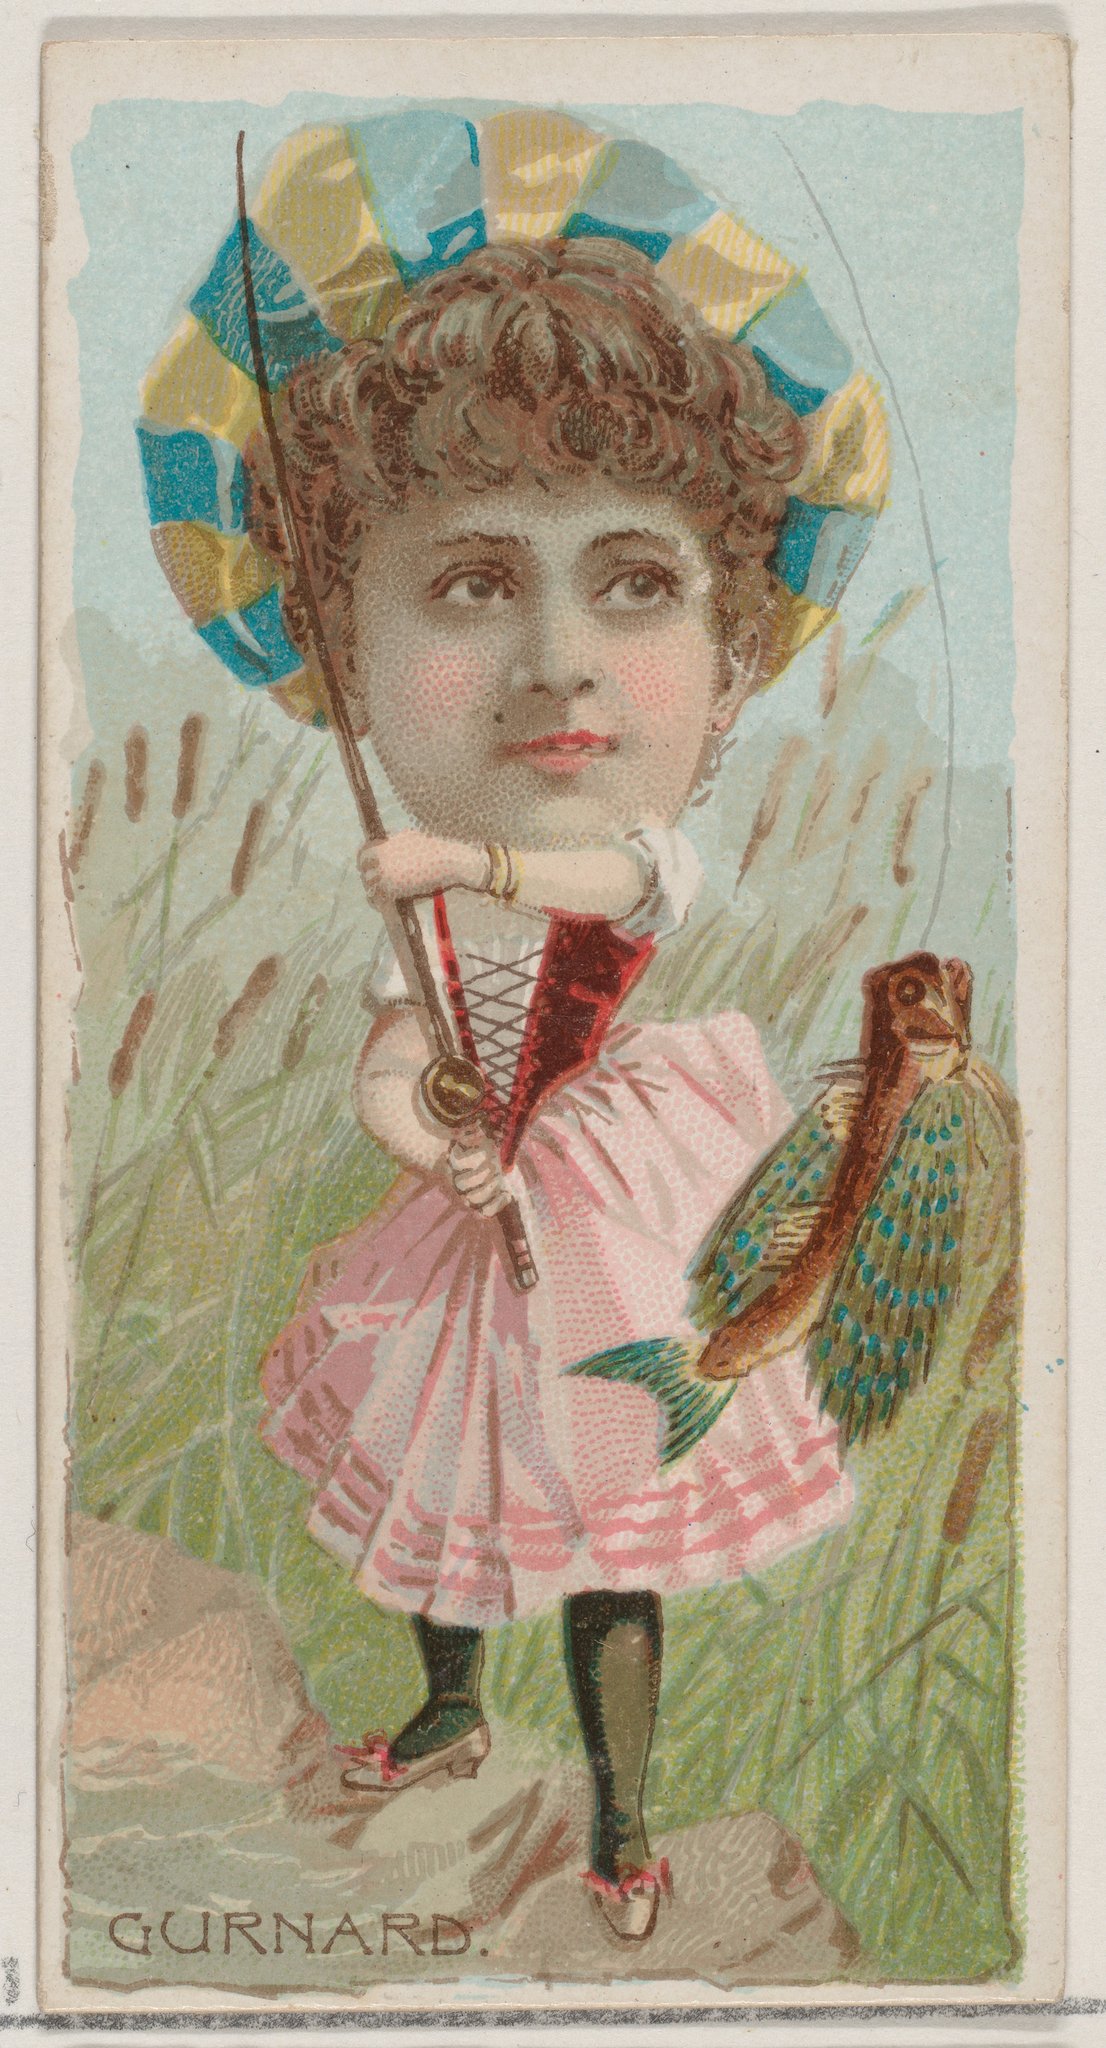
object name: print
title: Gurnard, from the series Fishers and Fish (N74) for Duke brand cigarettes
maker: knapp & company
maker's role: lithographer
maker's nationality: american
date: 1888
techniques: color lithograph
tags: women,fishing,fish